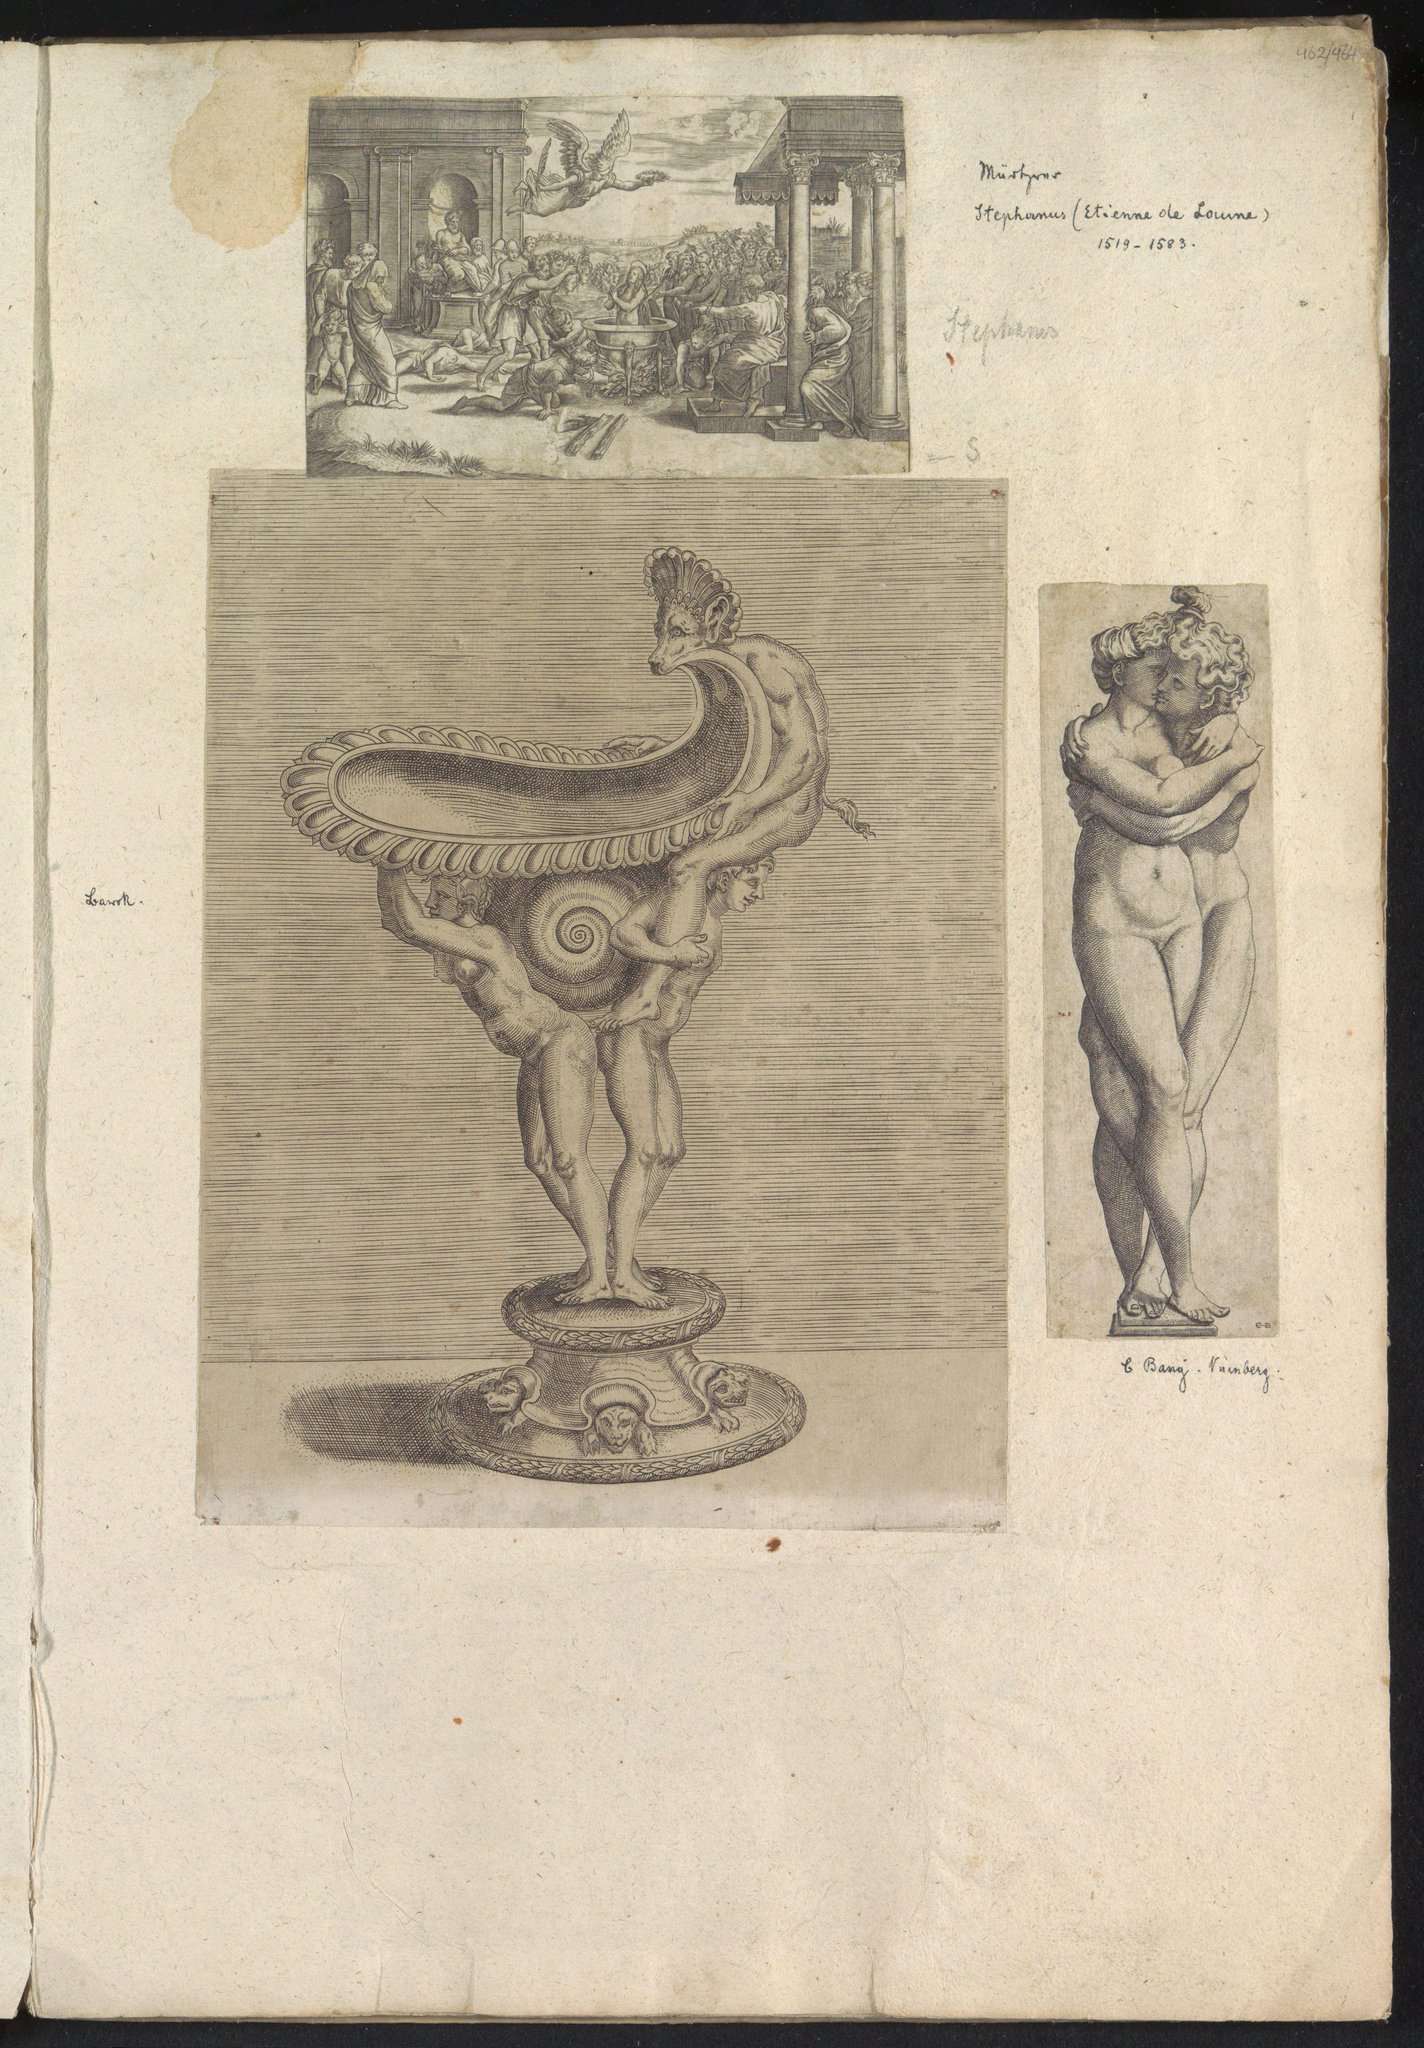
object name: ornament print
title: Albumblad met drie prenten met twee geliefden, een schaal en het martelen van Felicitas van Rome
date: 1500-1599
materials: paper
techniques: engraving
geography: france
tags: (lovers) embracing each other, 'symplegma', martyrdom, suffering, misfortune, death of st. felicity, dish, plate, saucer, couple of lovers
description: Albumblad met drie uitgeknipte prenten: een voorstelling van een menigte die Felicitas van Rome levend kookt in een grote ketel, een ornamentele schaal op een hoge poot en een innig verstrengeld paar geliefden.